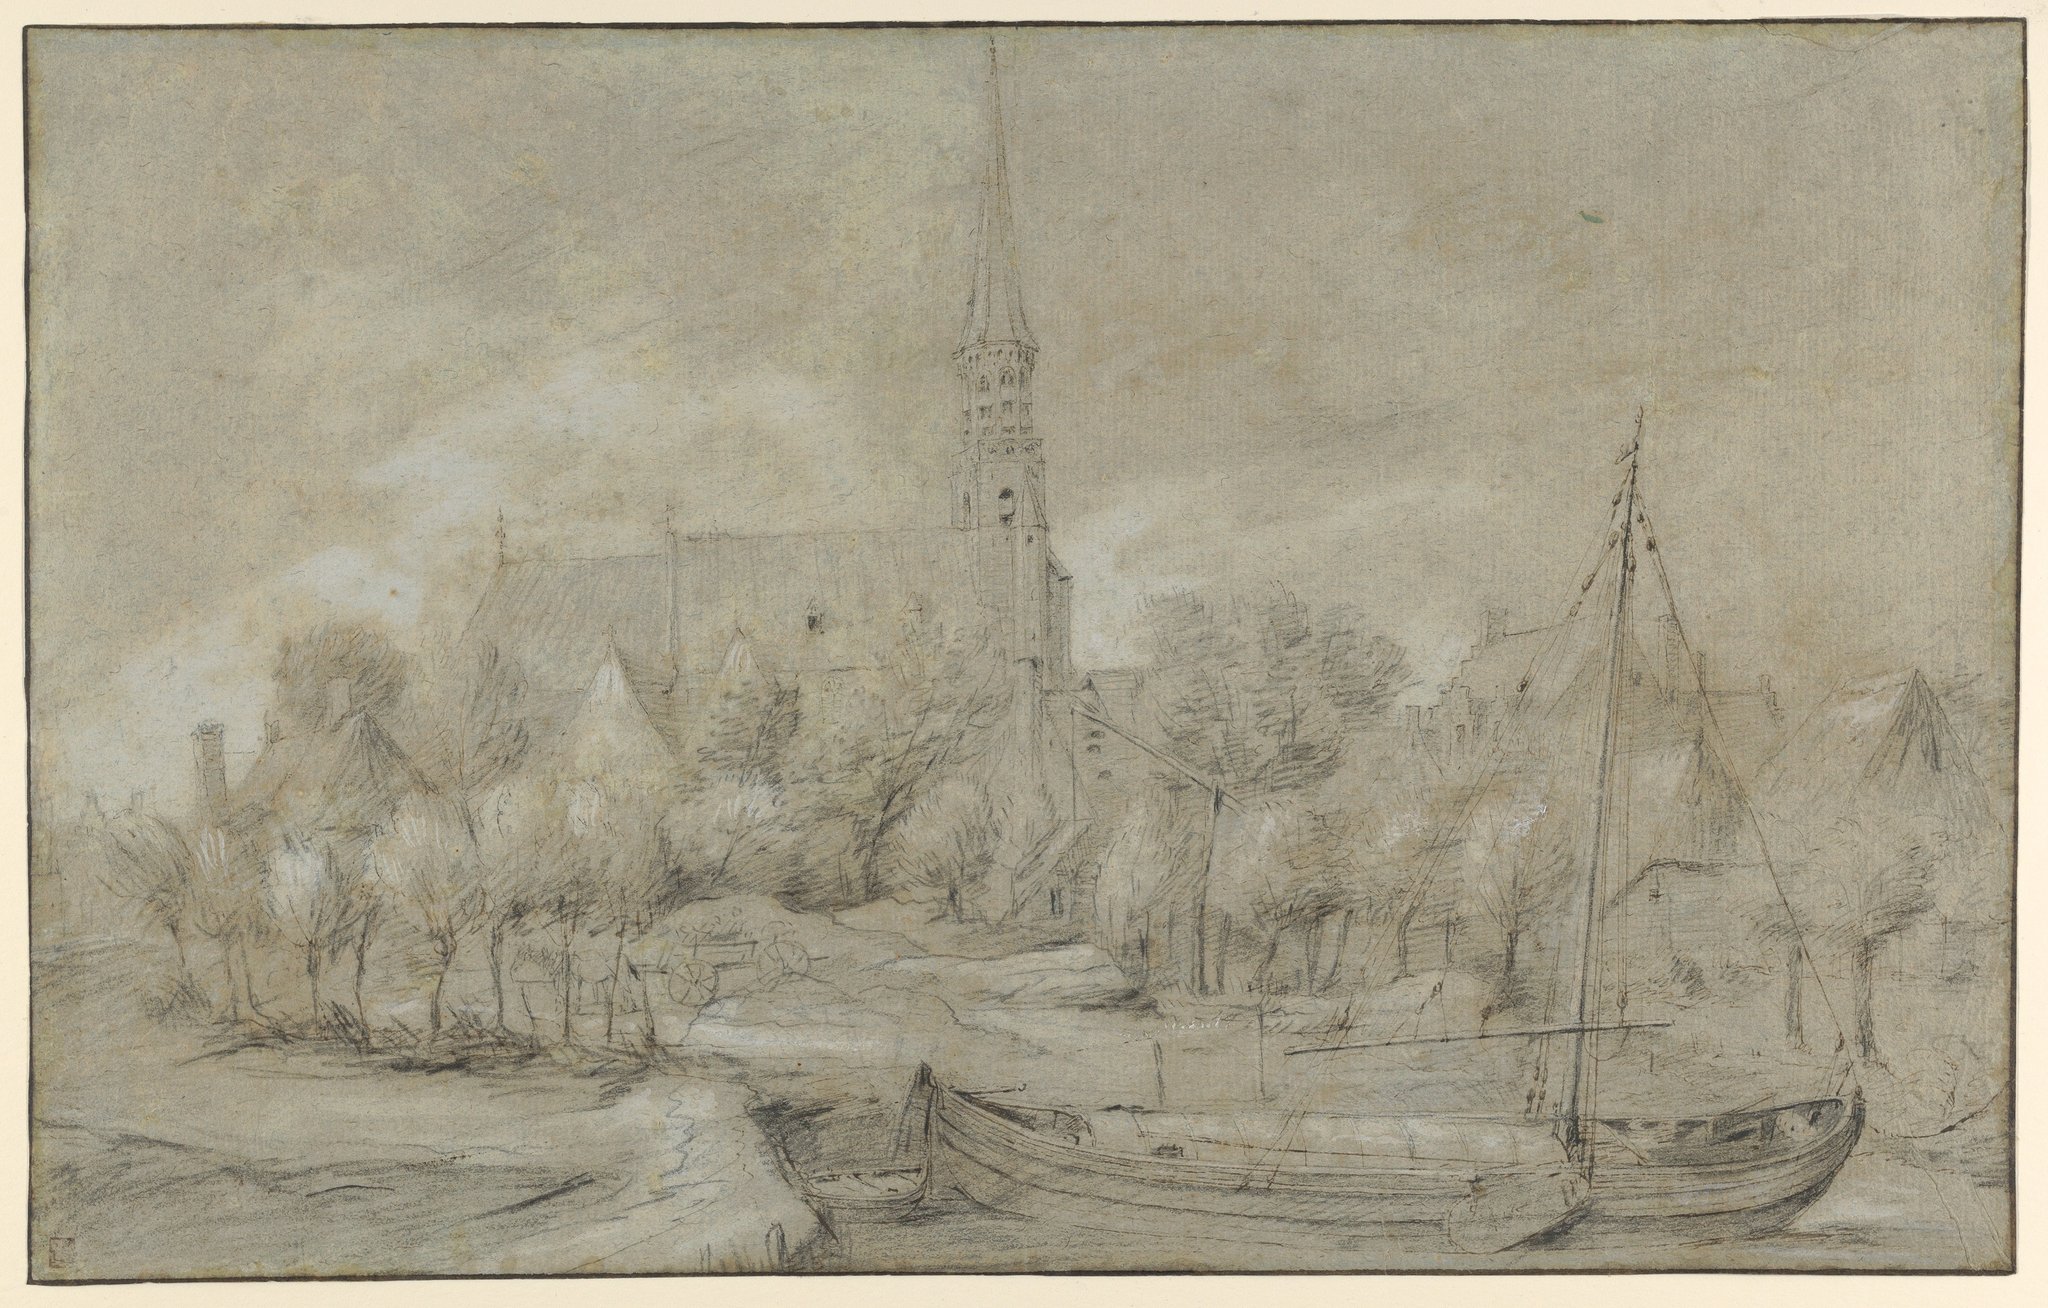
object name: drawing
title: The Church of Saints Peter and Paul in Schelle, near Antwerp, seen from the North, with a Boat in the river Vliet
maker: anonymous, flemish, 17th century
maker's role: artist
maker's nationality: flemish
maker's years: 1600-1700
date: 1634-1666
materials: chalk, gouache, ink, paper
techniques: heightening, pen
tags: churches,rivers,trees,boats